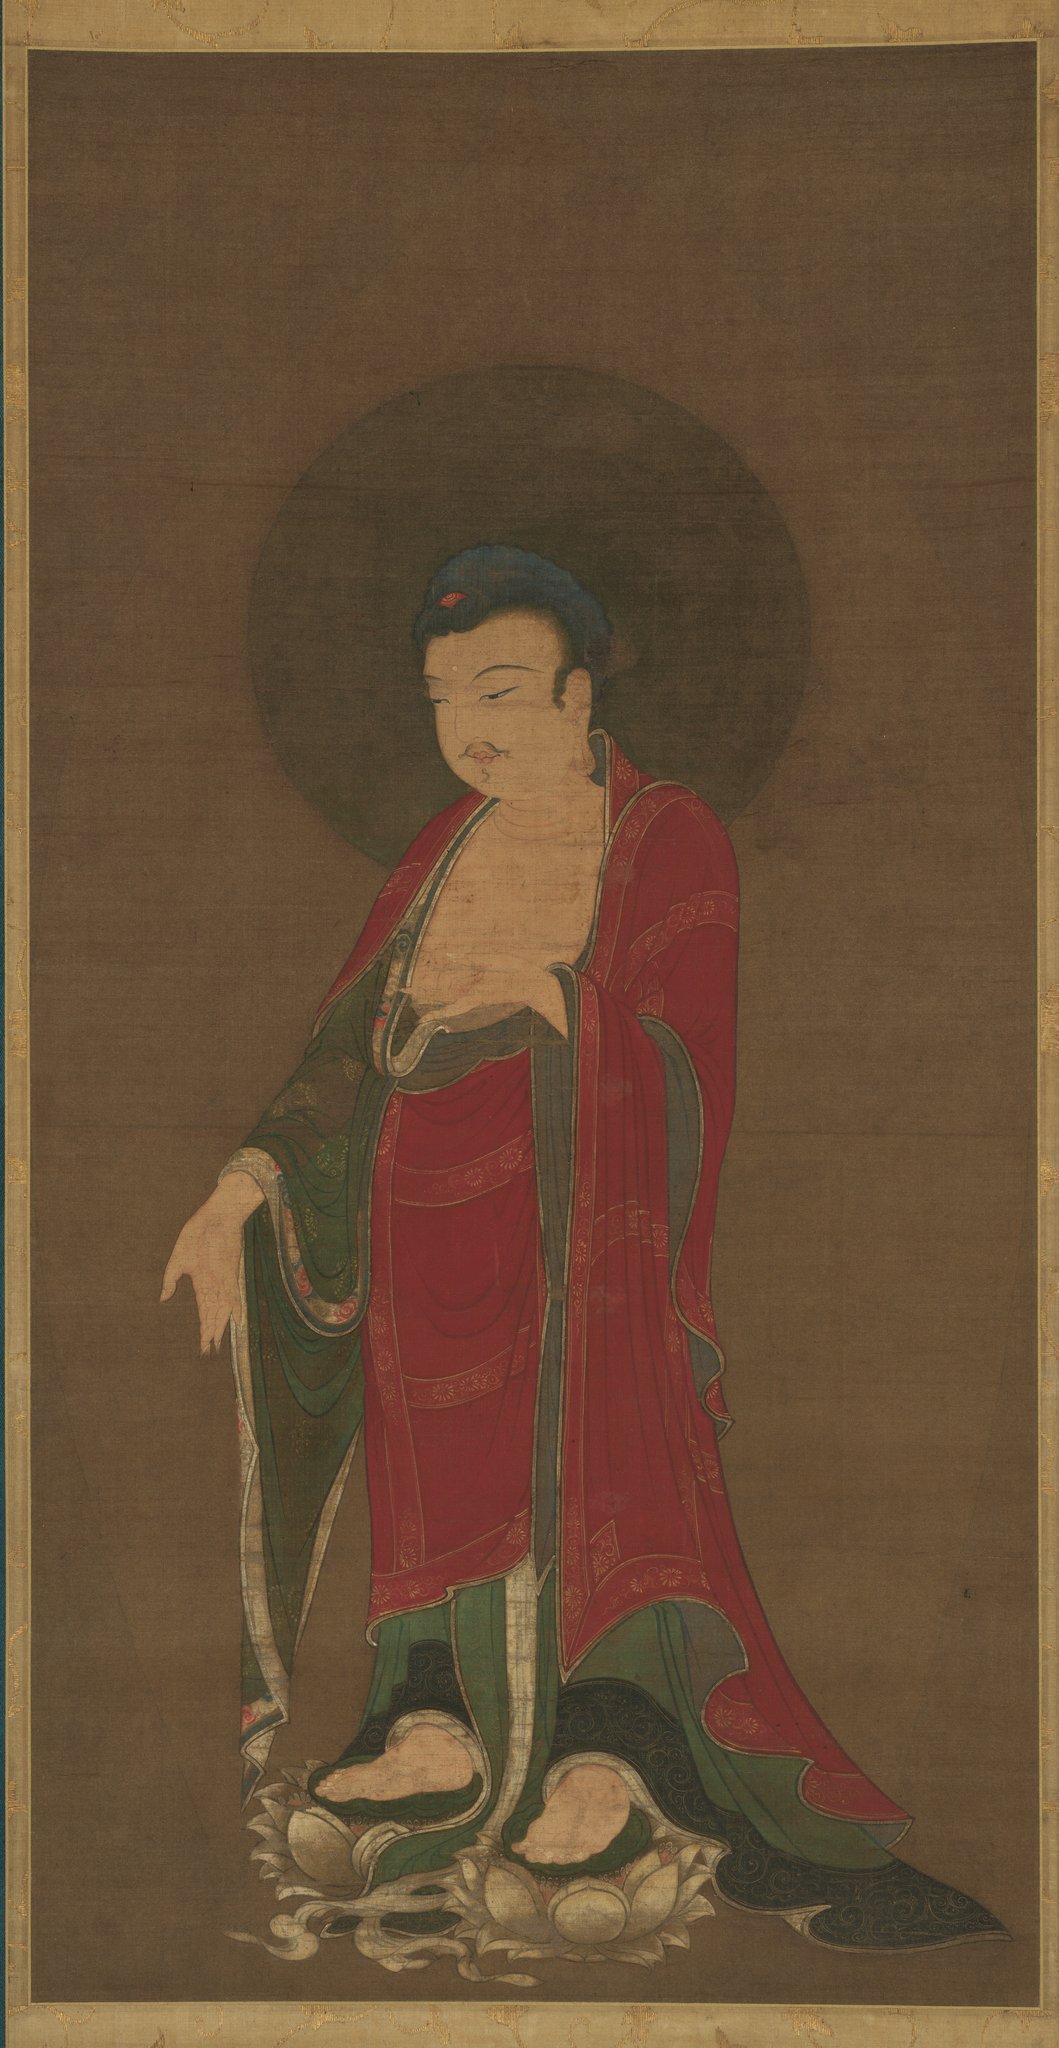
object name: hanging scroll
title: Buddha Amitabha Descending from His Pure Land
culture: chinese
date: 1267-1300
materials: gold, ink, silk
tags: buddhism,buddha